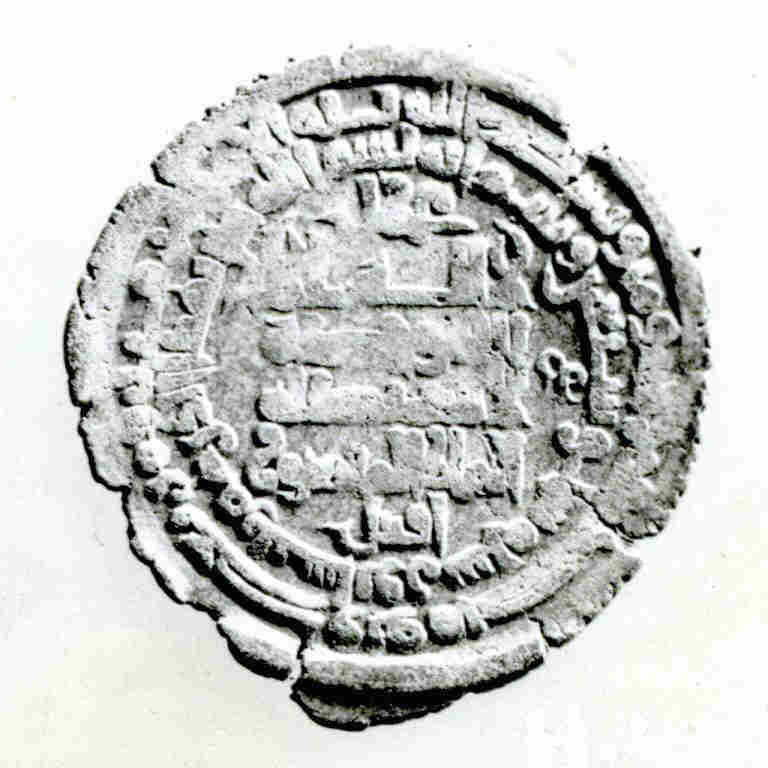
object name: coin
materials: silver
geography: iran